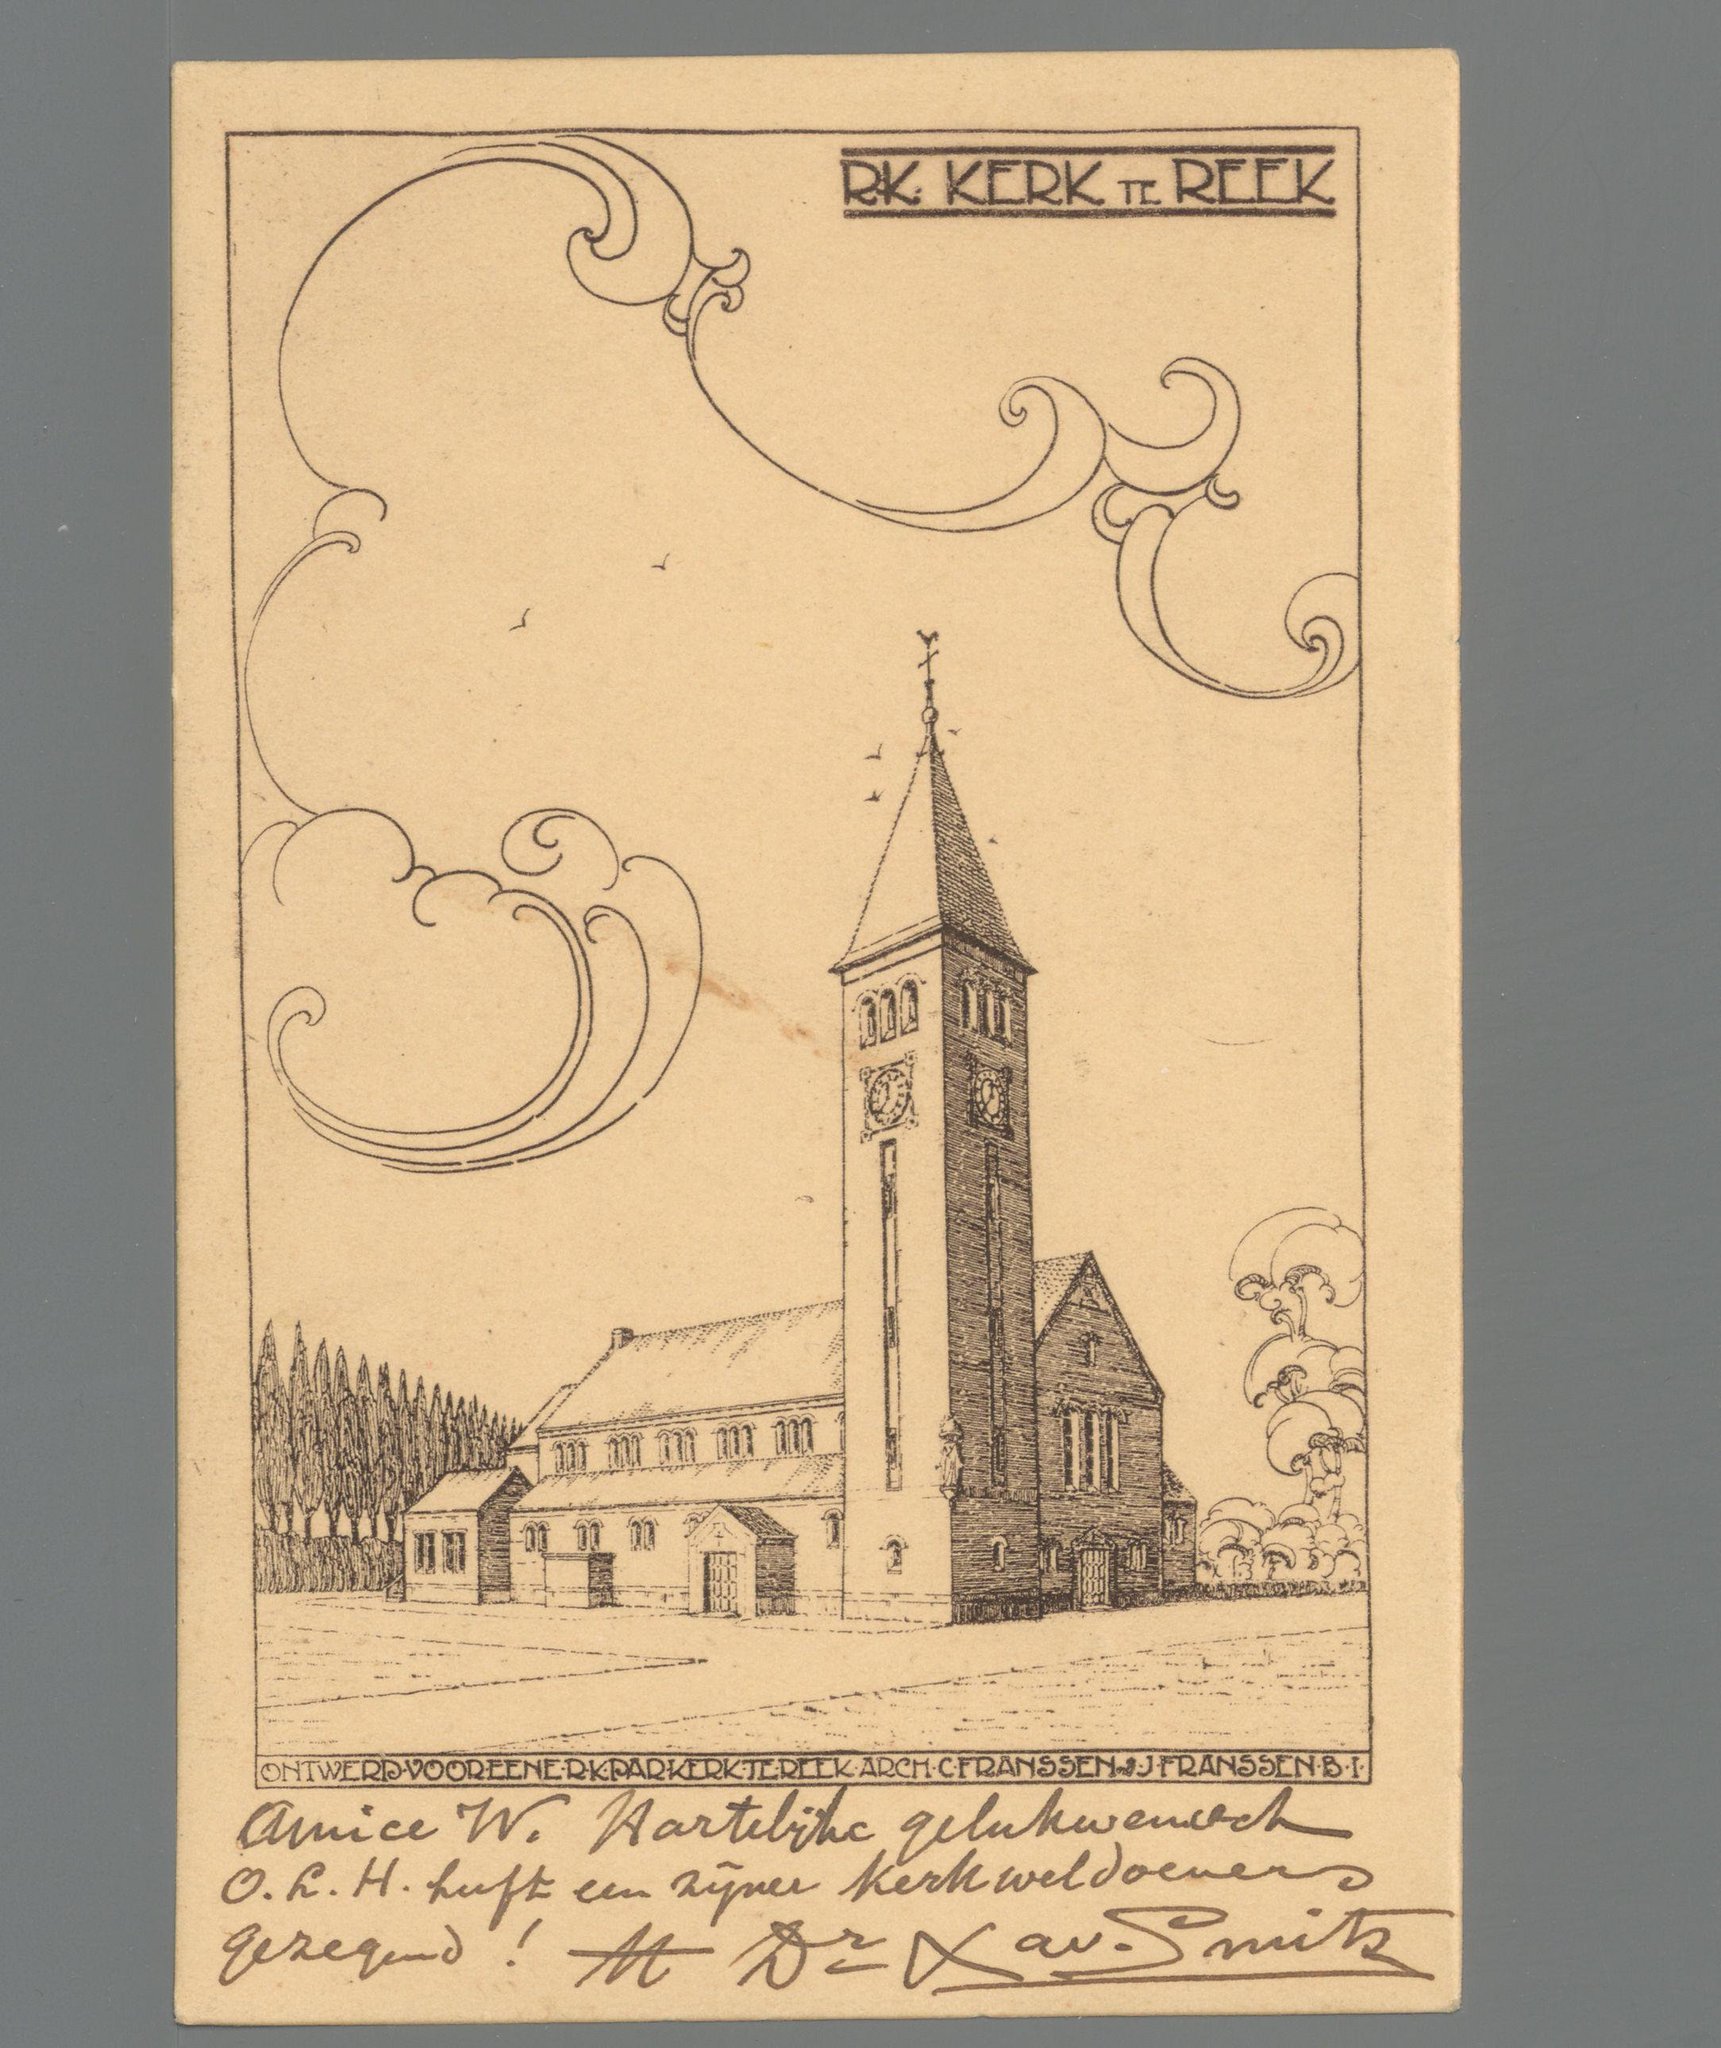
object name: photomechanical print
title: RK. Kerk te Reek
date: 1923-1930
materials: cardboard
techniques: photograph, writing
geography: reek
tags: church (exterior)